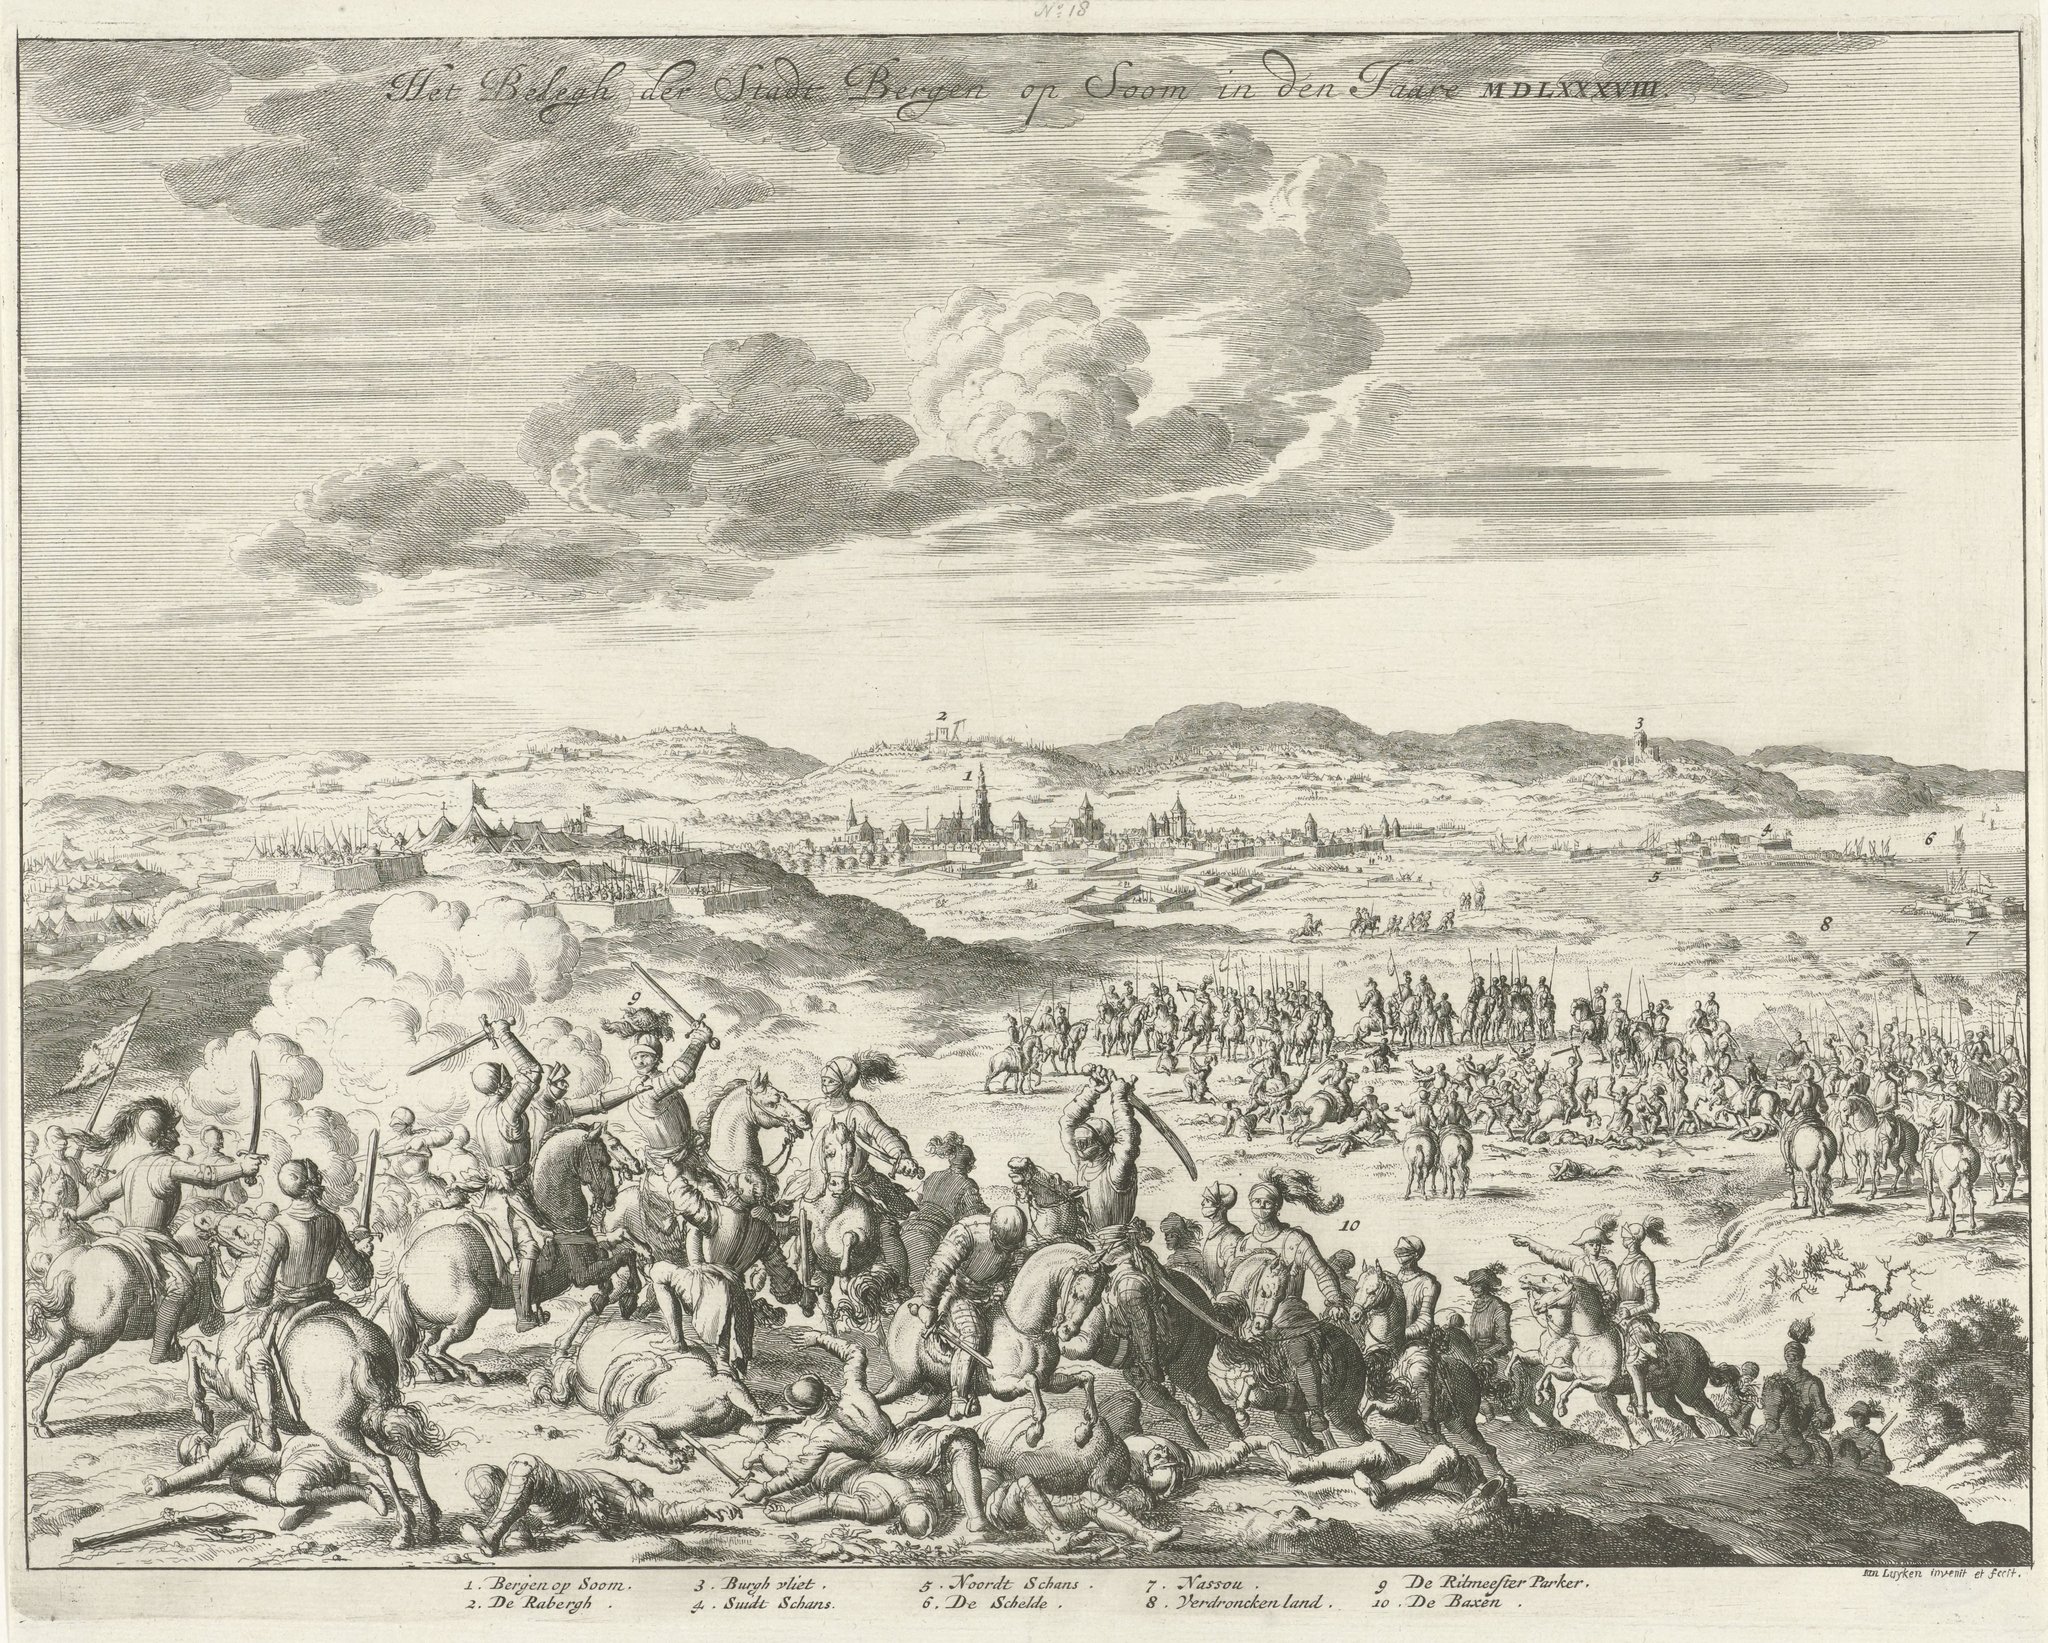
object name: print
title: Beleg van Bergen op Zoom, 1588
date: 1679-1684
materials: paper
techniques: etching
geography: amsterdam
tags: siege, position war, battle, bergen op zoom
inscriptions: collector's mark: Lugt 2228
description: Illustratie gebruikt in: Bor Christiaansz, Pieter. Oorsprongk, begin, en vervolgh der Nederlandsche oorlogen, 4 delen. Amsterdam: weduwe Joannes van Someren, Abraham Wolfgang, Hendrick en Dirk Boom, 1679-1684, dl. III, p. 339.